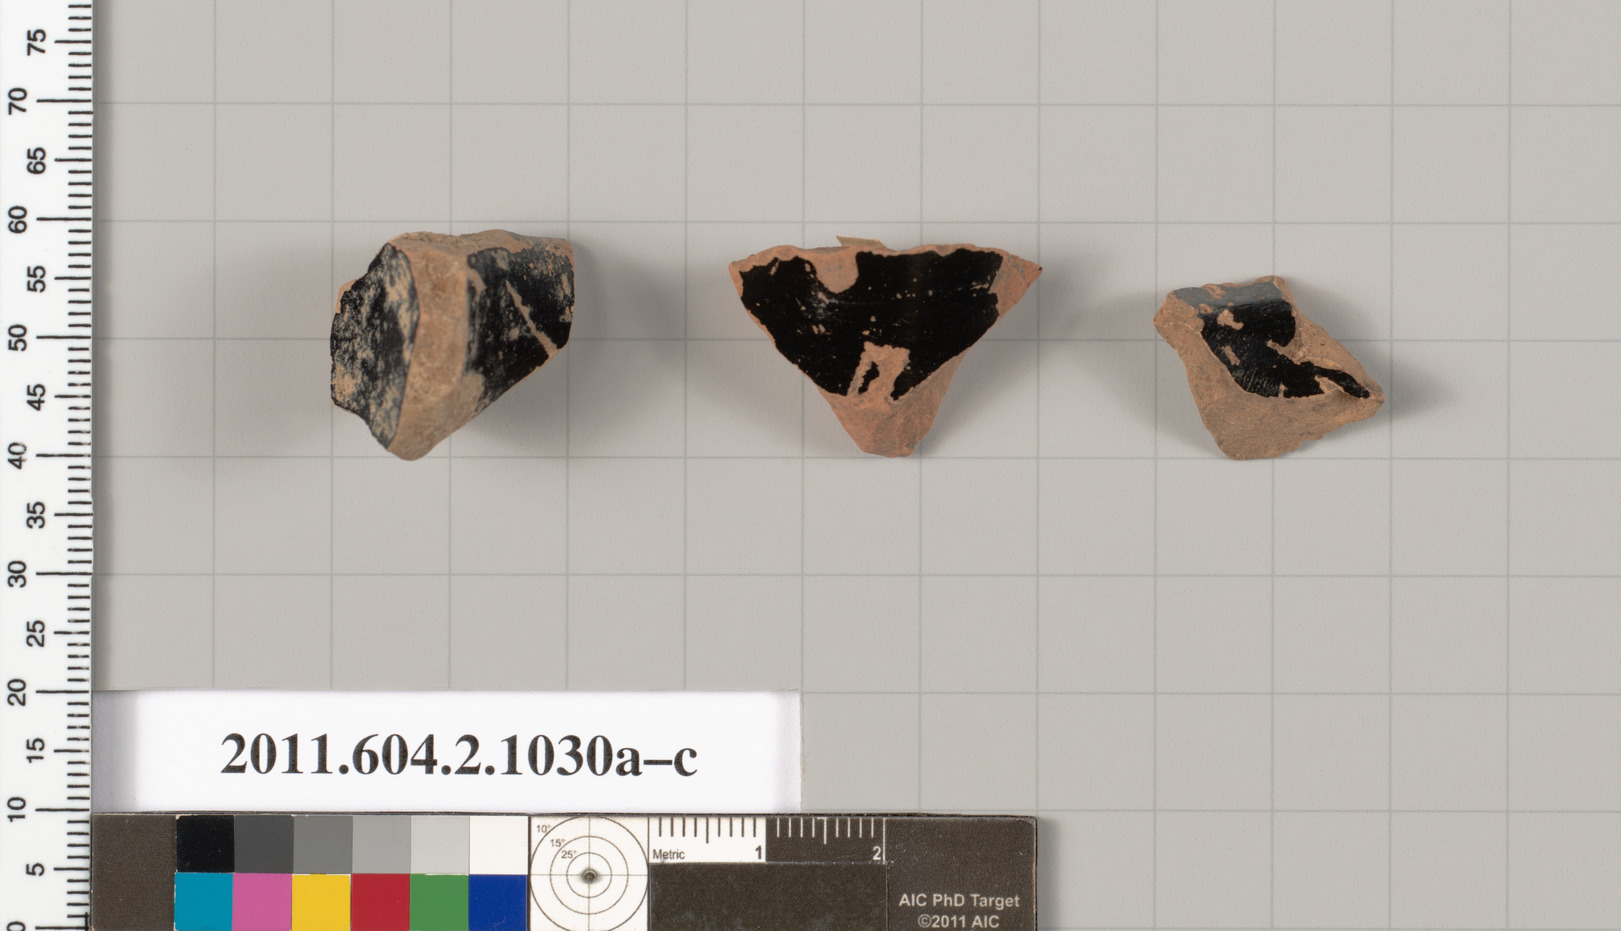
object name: oinochoe fragment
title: Terracotta fragments of oinochoai (jugs)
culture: greek, attic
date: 475-425 BCE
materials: terracotta